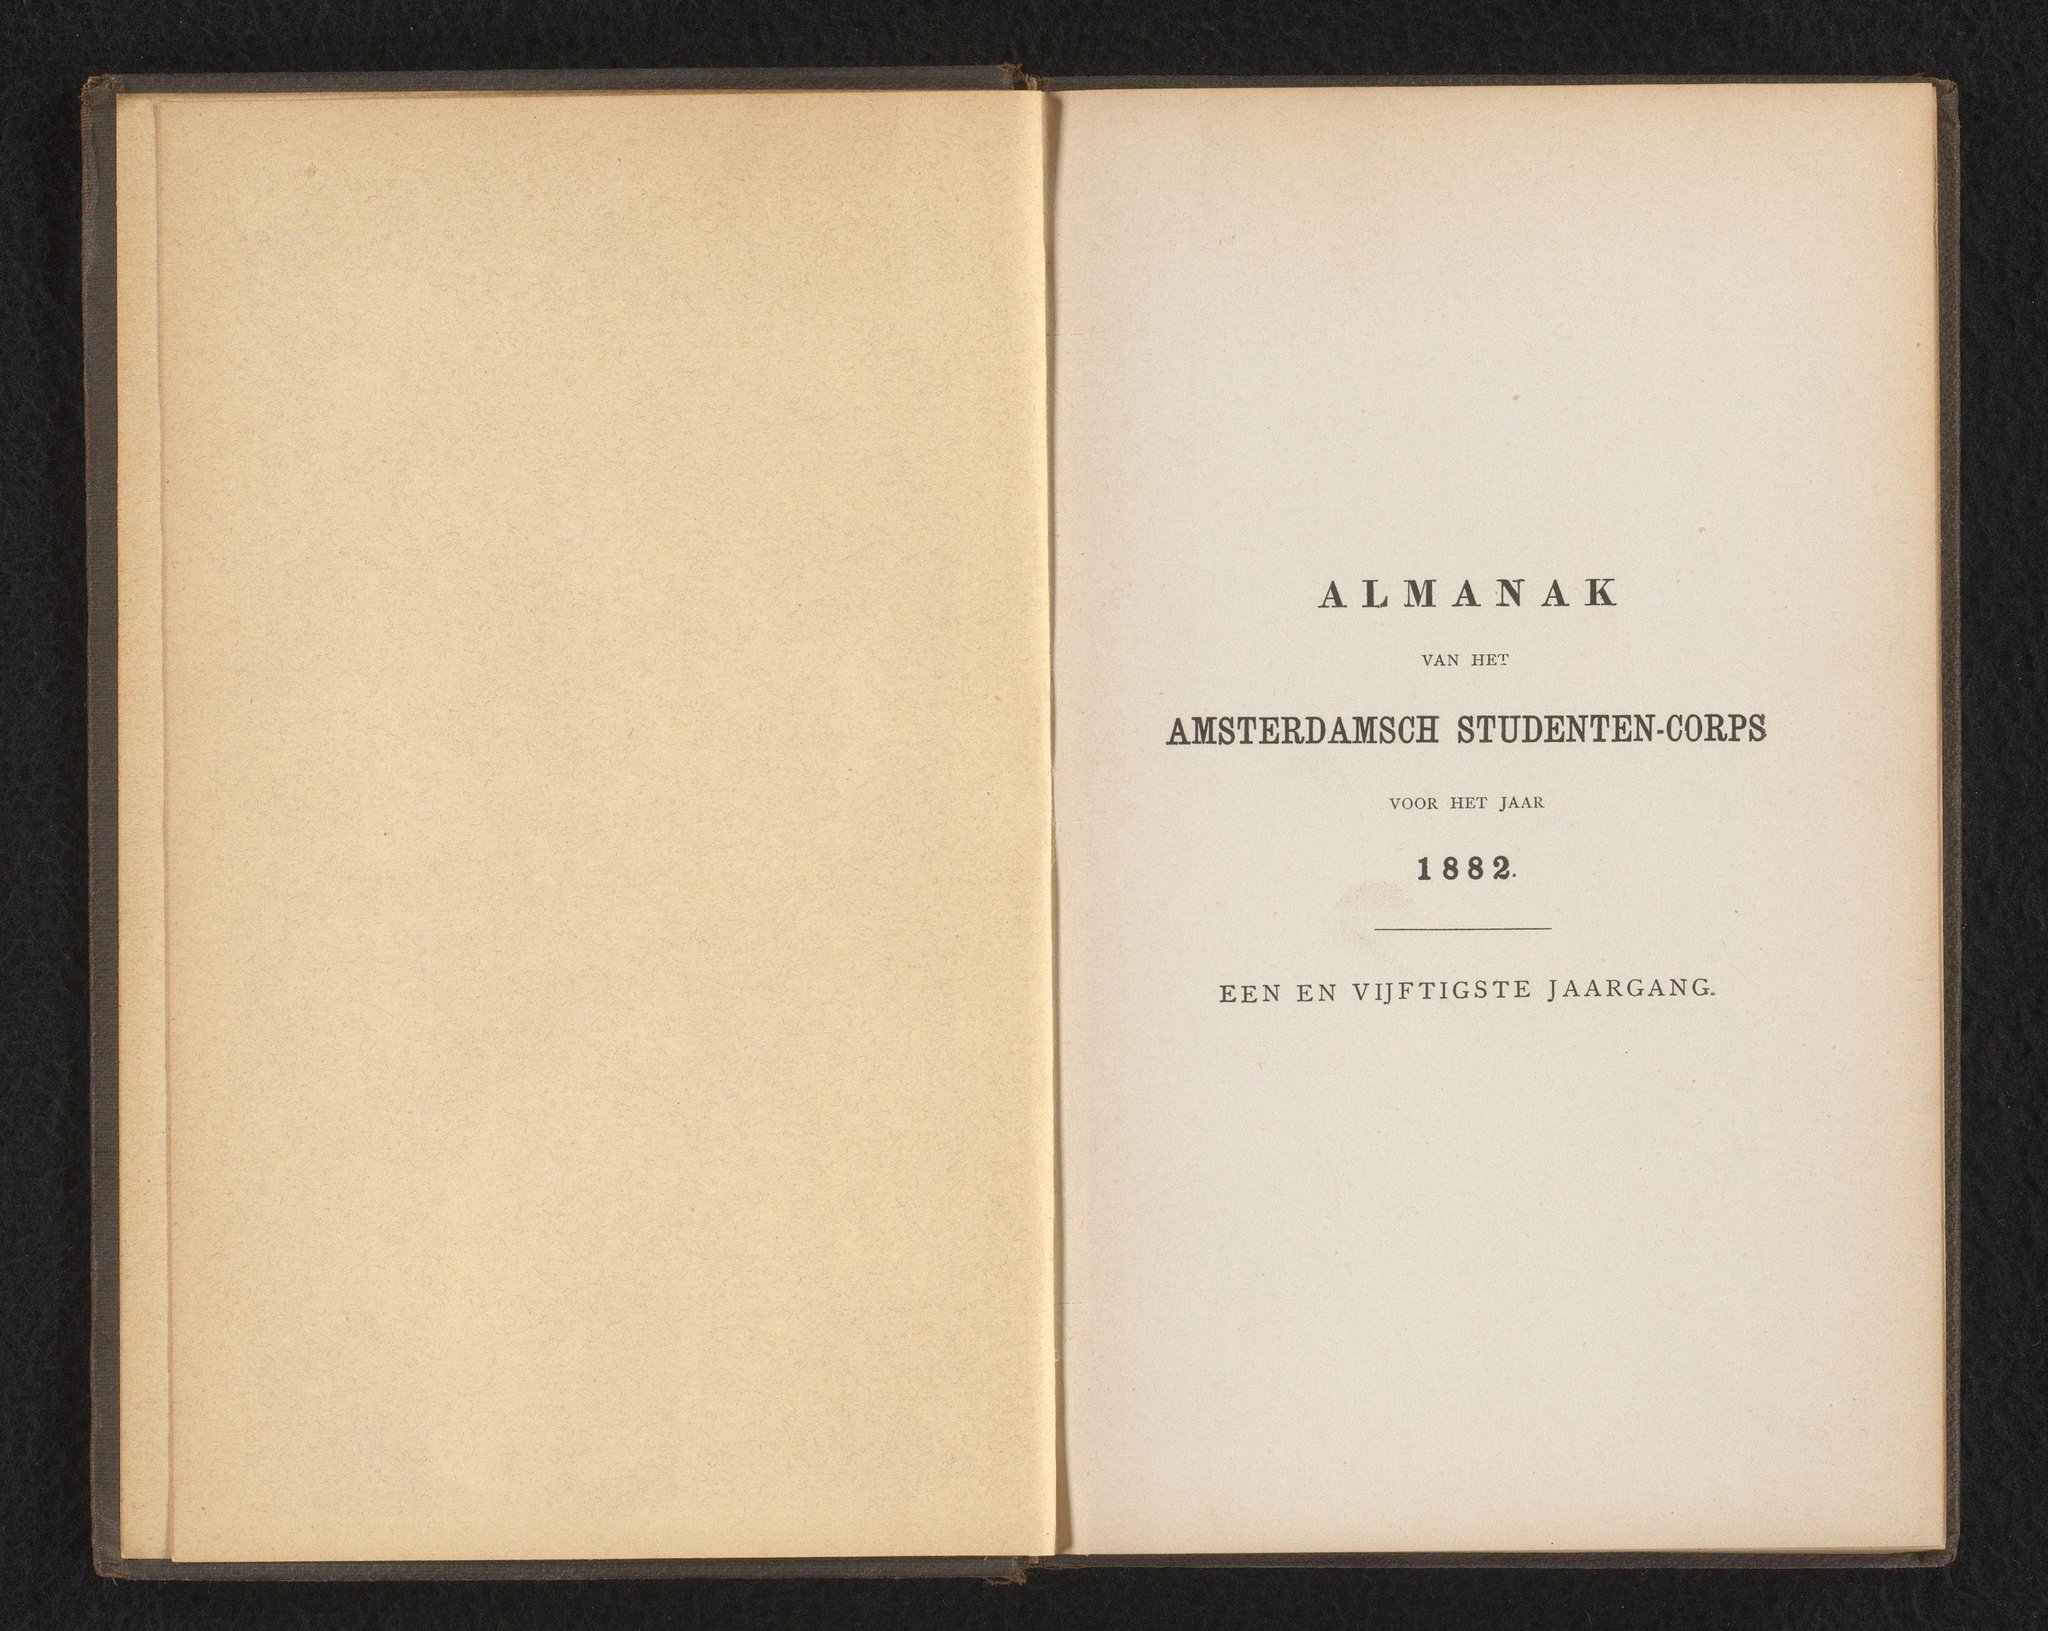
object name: book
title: Almanak van het Amsterdamsch studenten-corps voor het jaar 1882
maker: d.g. van bommel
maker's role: boekbinder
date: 1882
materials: paper, cardboard, linen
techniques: albumen print, engraving, letterpress printing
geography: amsterdam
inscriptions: number: ‘2224’, company name: ‘D.G. van Bommel/ Boekbinder/ Amsterdam’, inscription: ‘gekocht dec 1964 f3,75/ bij Kok Amsterdam’